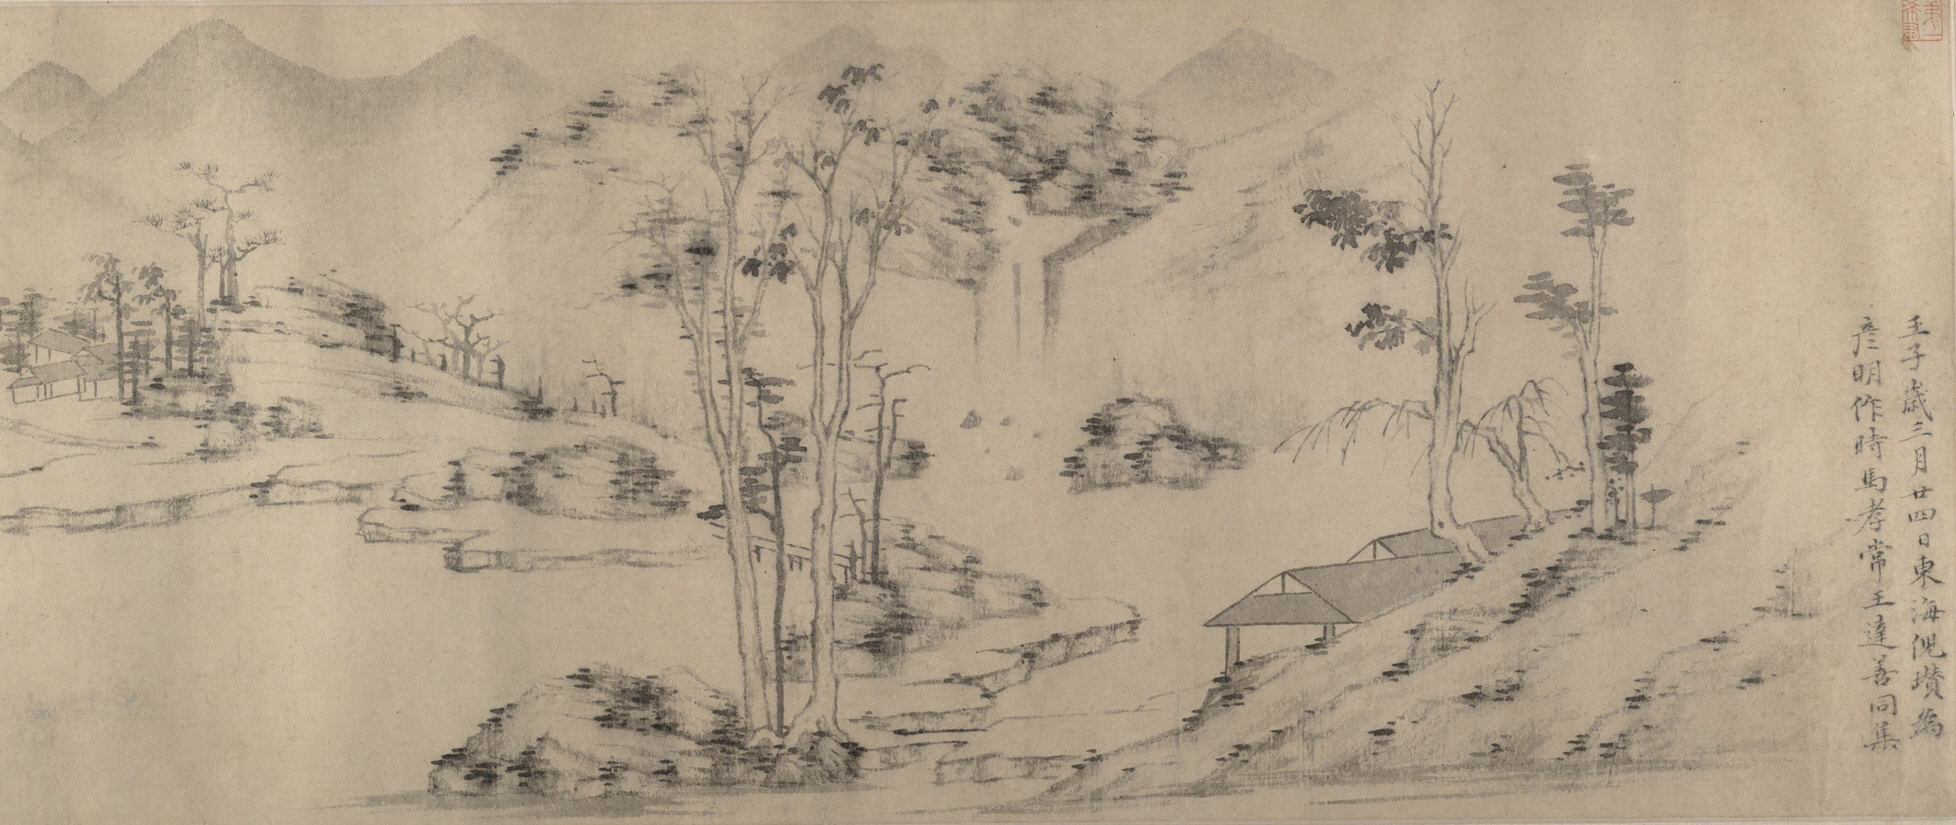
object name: handscroll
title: River Landscape with Thirteen Inscriptions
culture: chinese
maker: unidentified artist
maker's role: artist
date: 1368-1911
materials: paper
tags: rivers,landscapes